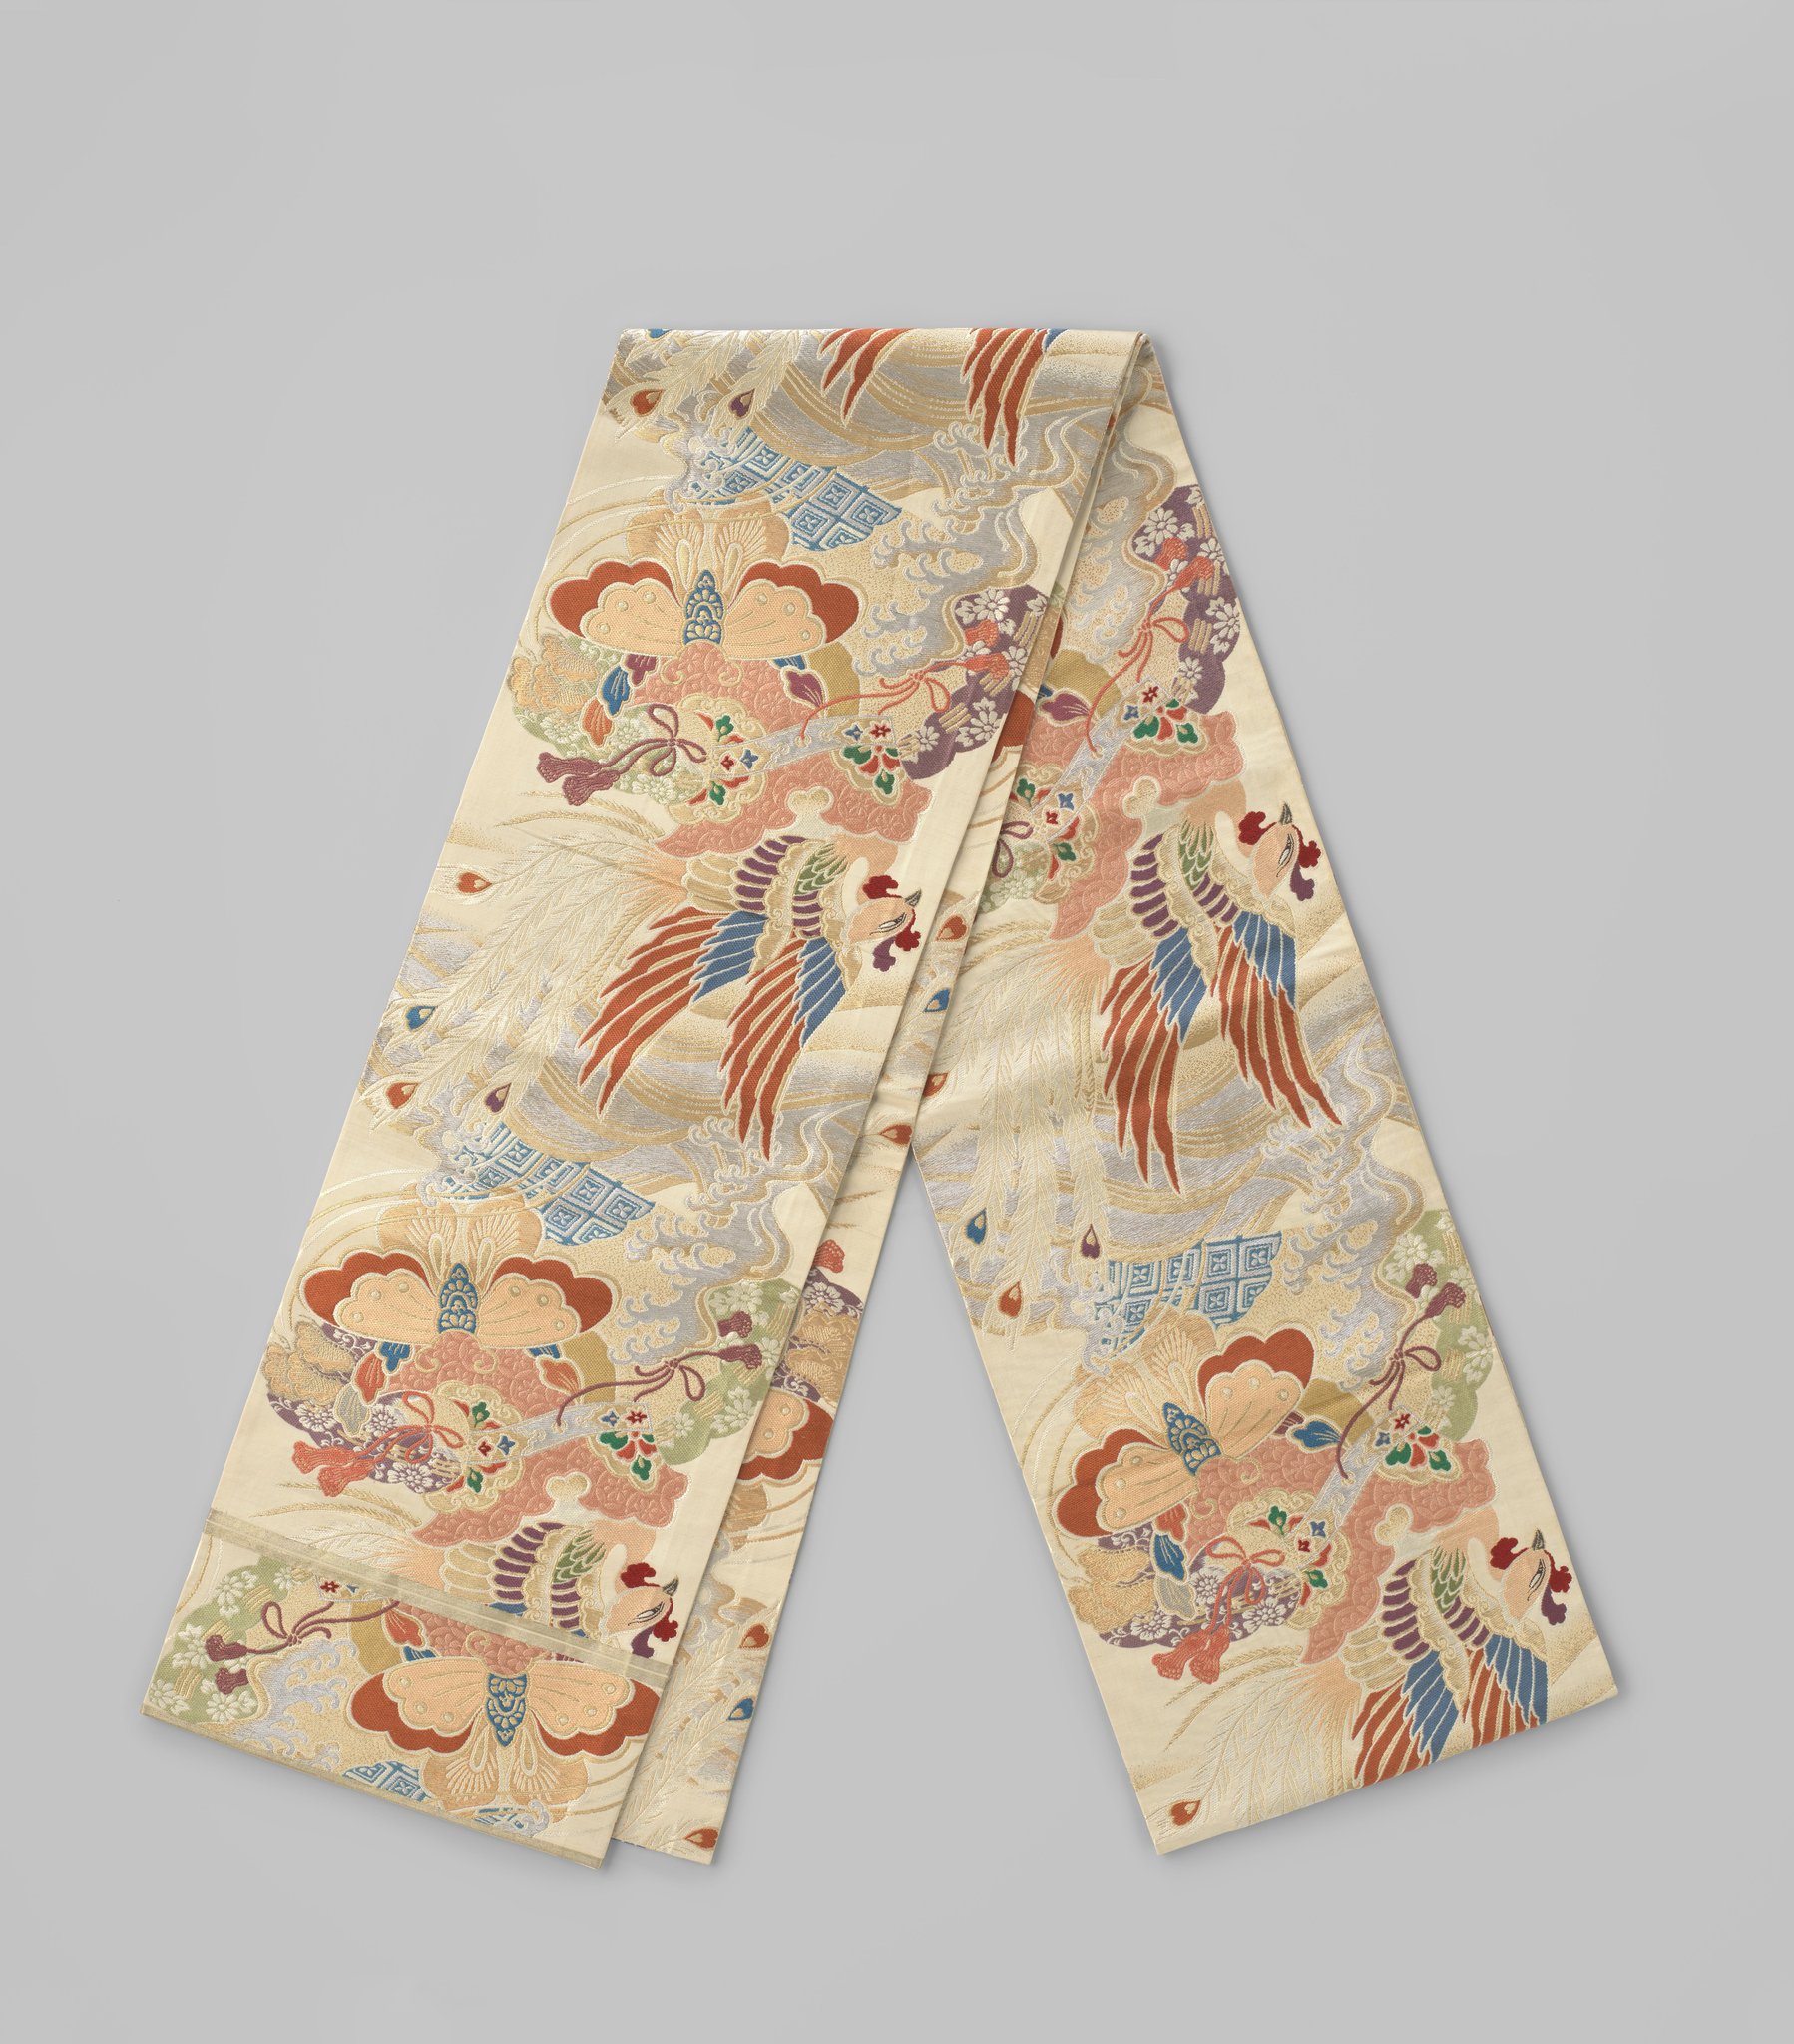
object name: obi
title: Vrouwen maru obi met motieven uit Hagoromo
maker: Anonymous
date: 1950-1980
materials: silk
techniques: weave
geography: japan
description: Ceintuur van zijdebrokaat voor een formele kimono (maru obi) voor een vrouw, met een versiering over het hele vlak van verschillende attributen uit het No toneelstuk Hagoromo ('Het Verenkleed'): een hoofdtooi met een Hoo-vogel, golven, pijnboom en een vlinder. Roomwitte zijde met brokaat geweven decoratie (nishiki).